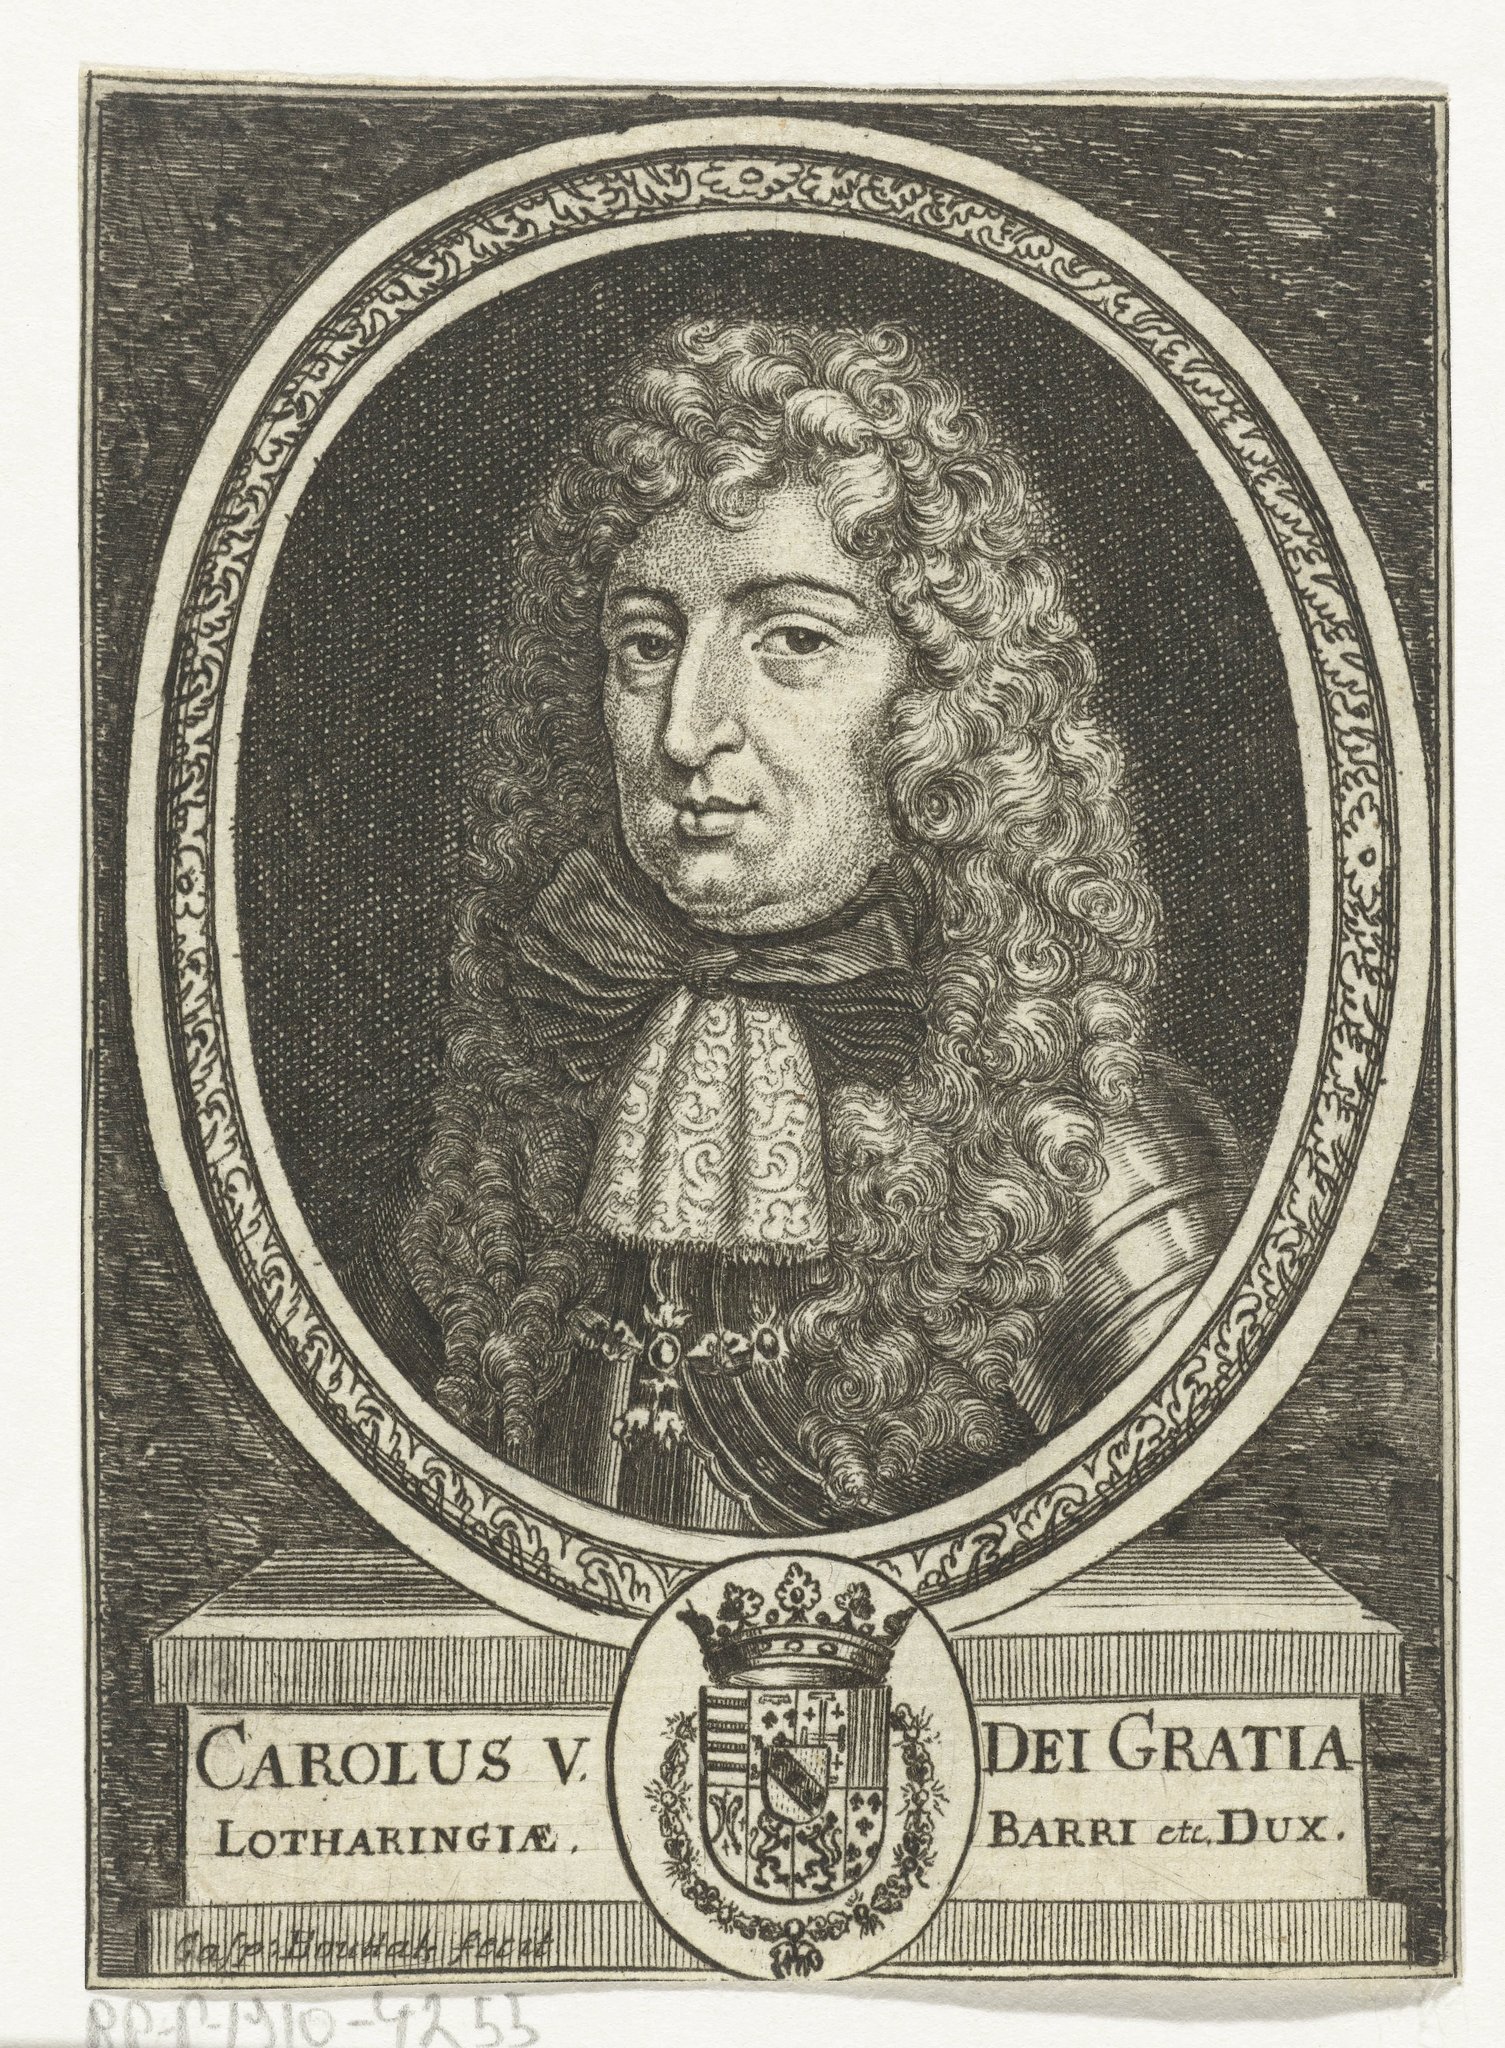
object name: print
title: Calolvs V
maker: gaspar bouttats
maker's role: print maker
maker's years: 1640-1695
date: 1675-1695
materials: paper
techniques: engraving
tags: vienna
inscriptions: collector's mark: Lugt 2228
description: Portret in een ovale lijst van Karel V, hertog van Lotharingen. Buste naar links. Karel V draagt een harnas. Onder de prent het wapenschild van de hertogen van Lotharingen. De prent heeft een Latijns onderschrift met de naam van de geportretteerde.